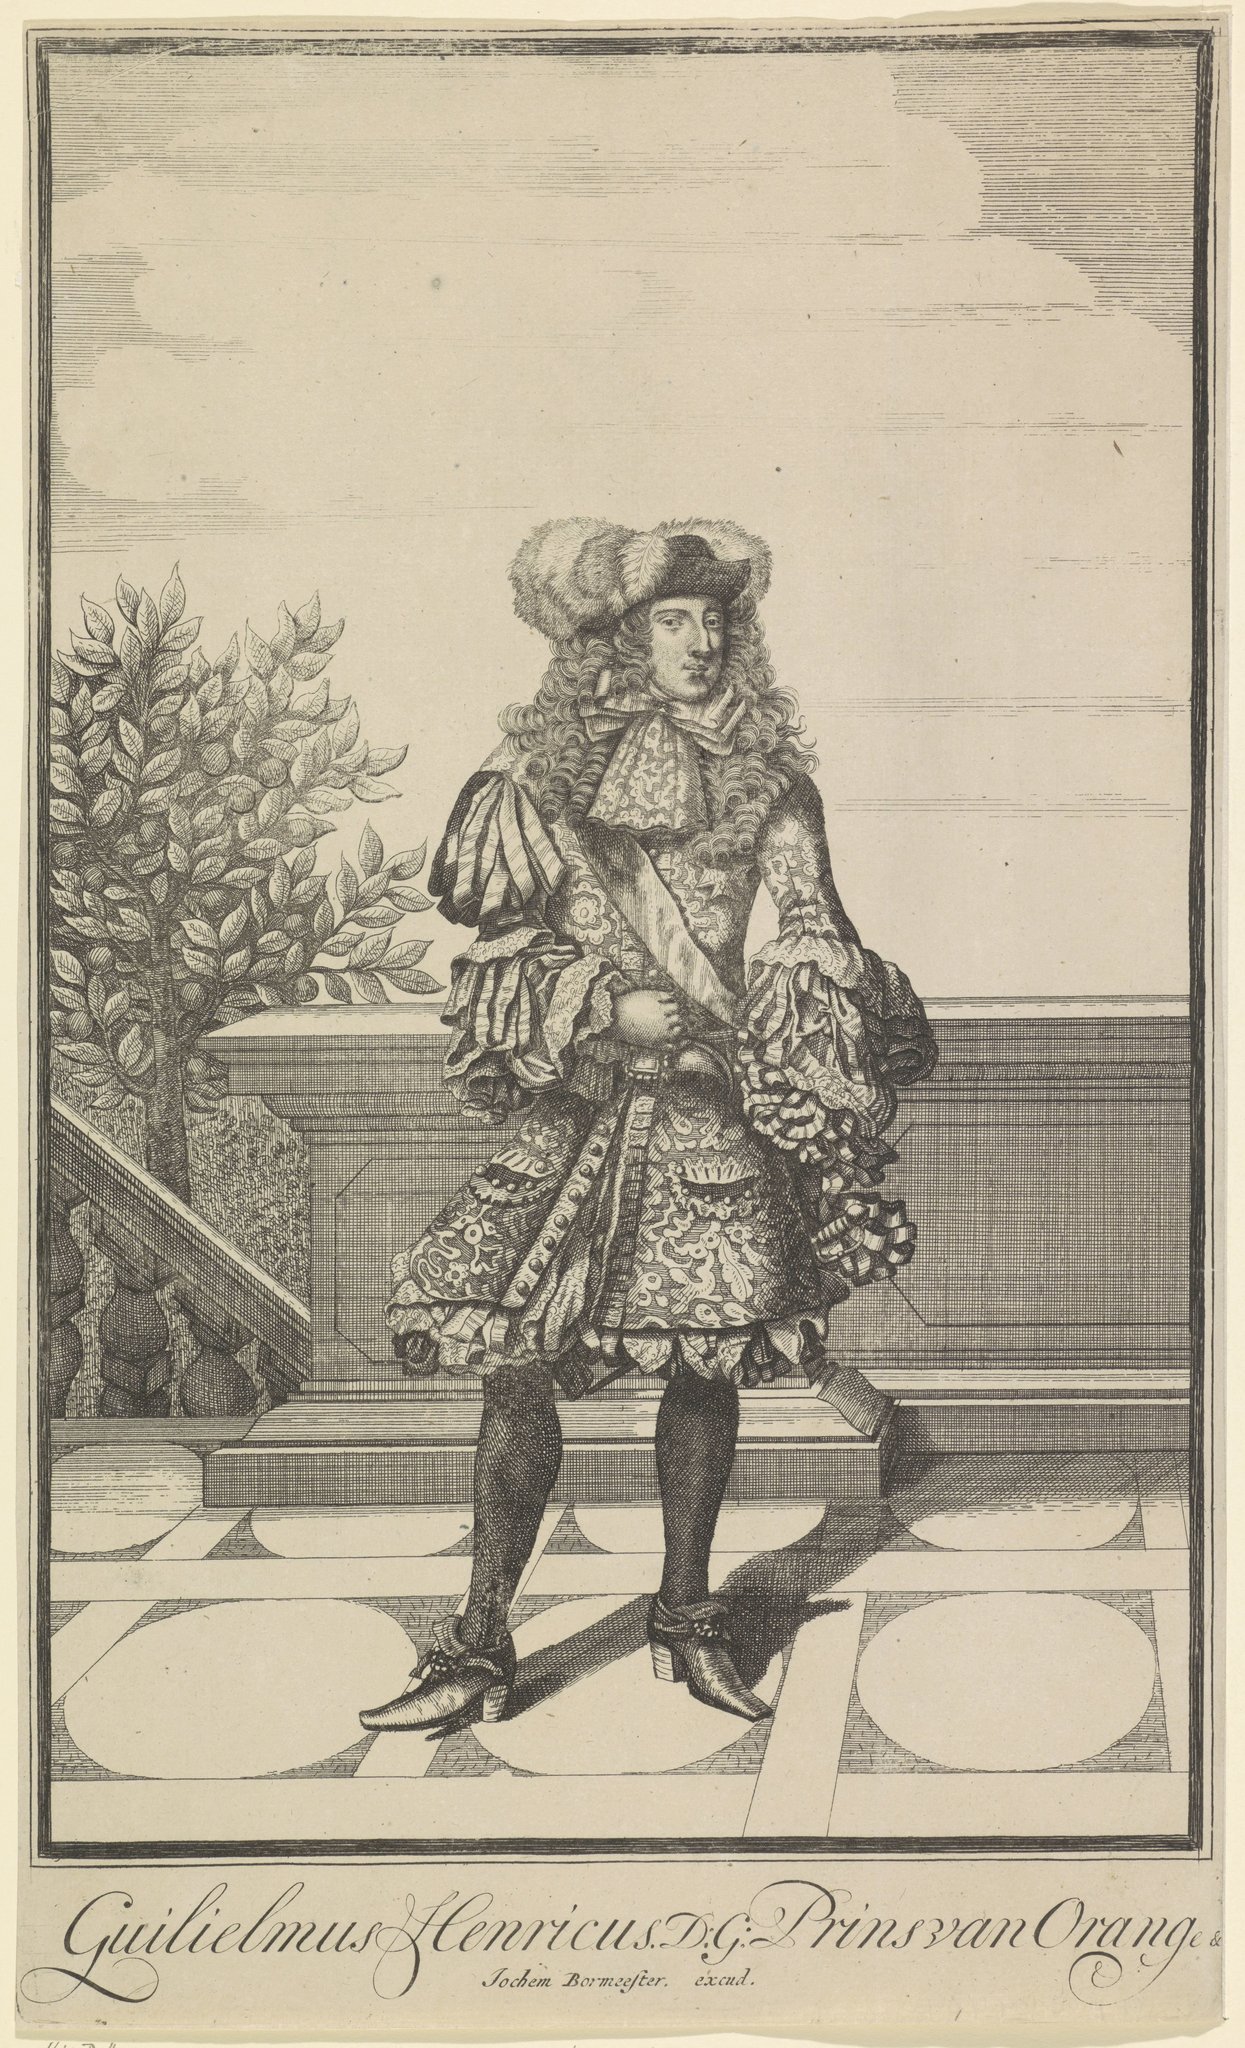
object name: print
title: Portret van Willem III, prins van Oranje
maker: jochem bormeester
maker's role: print maker, publisher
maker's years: -1702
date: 1670-1702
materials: paper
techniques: engraving, etching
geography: amsterdam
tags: william iii (prince of orange and king of england, scotland, and ireland)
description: De hier vermelde titel verwijst naar de hoogst verkregen titel van de geportretteerde, niet per se naar de titel die de geportretteerde op deze voorstelling draagt.